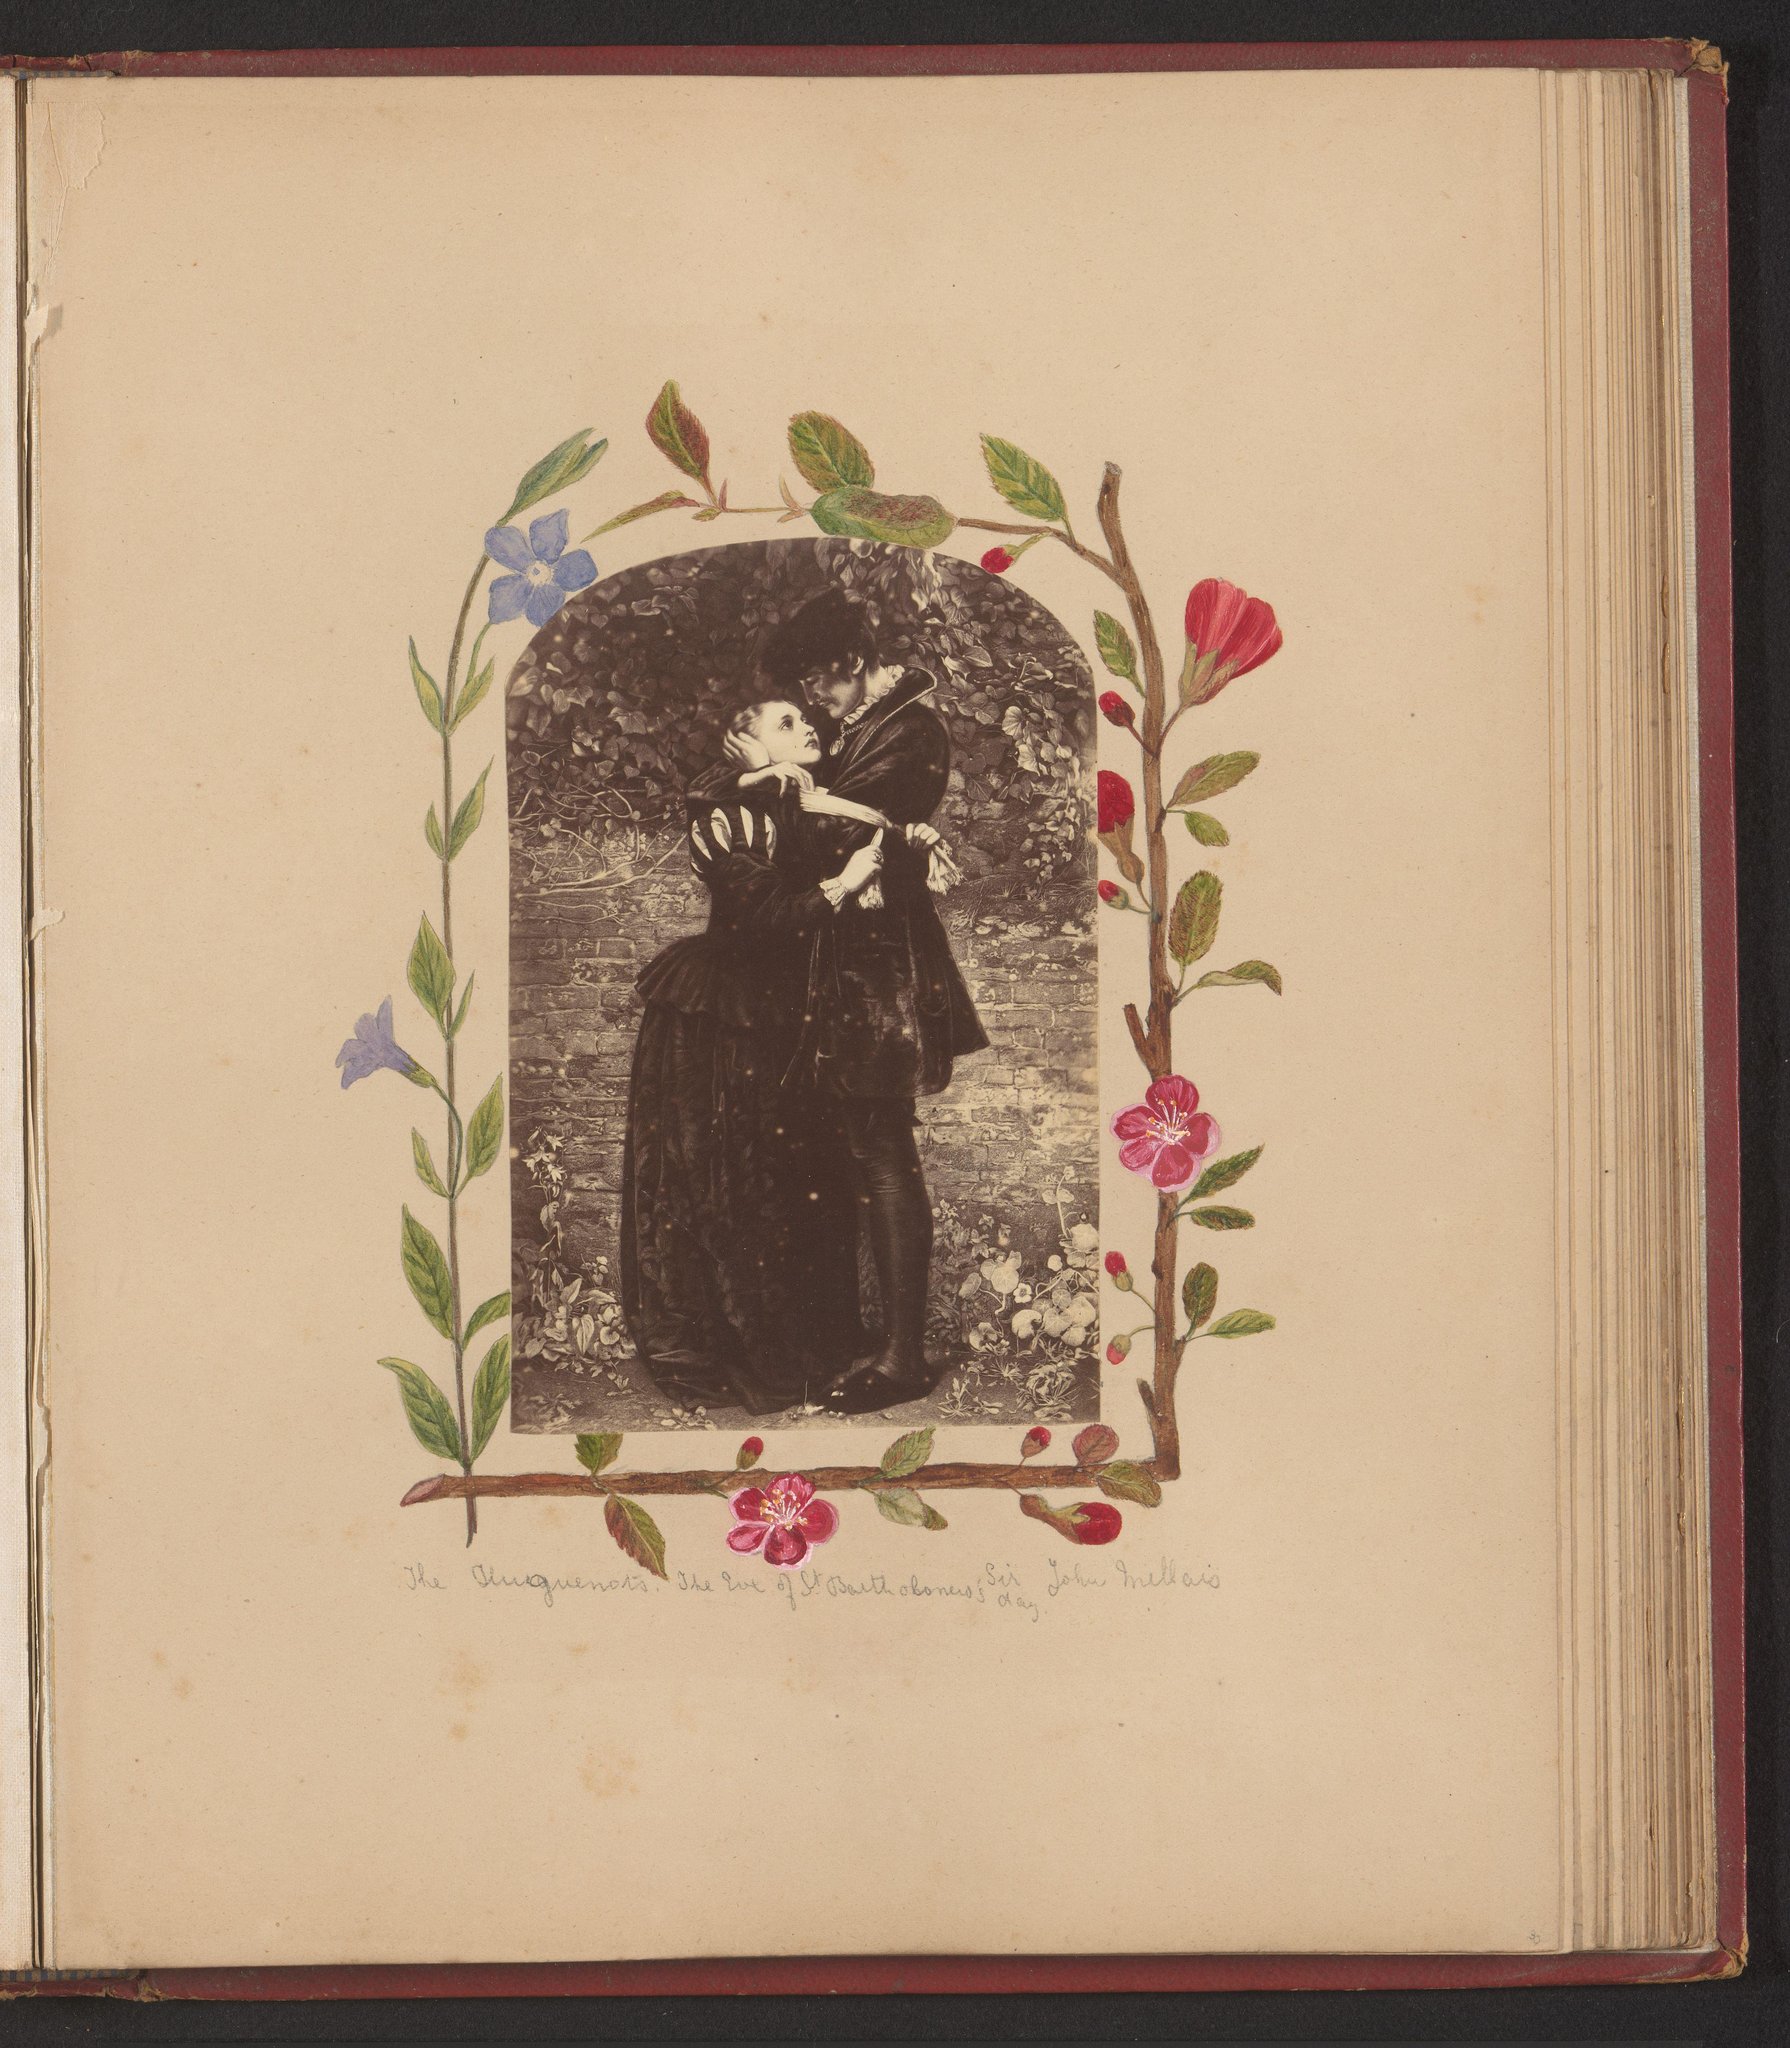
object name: reproduction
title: Fotoreproductie van A Huguenot, on St. Bartholomew's Day, Refusing to Shield Himself from Danger by Wearing the Roman Catholic Badge naar John Everett Millais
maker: Anonymous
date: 1875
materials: photographic support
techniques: albumen print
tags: embracing each other, kissing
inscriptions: annotation: ‘The hugenots. The eve of St. Bartholomeus's day, Sir John Mellais’